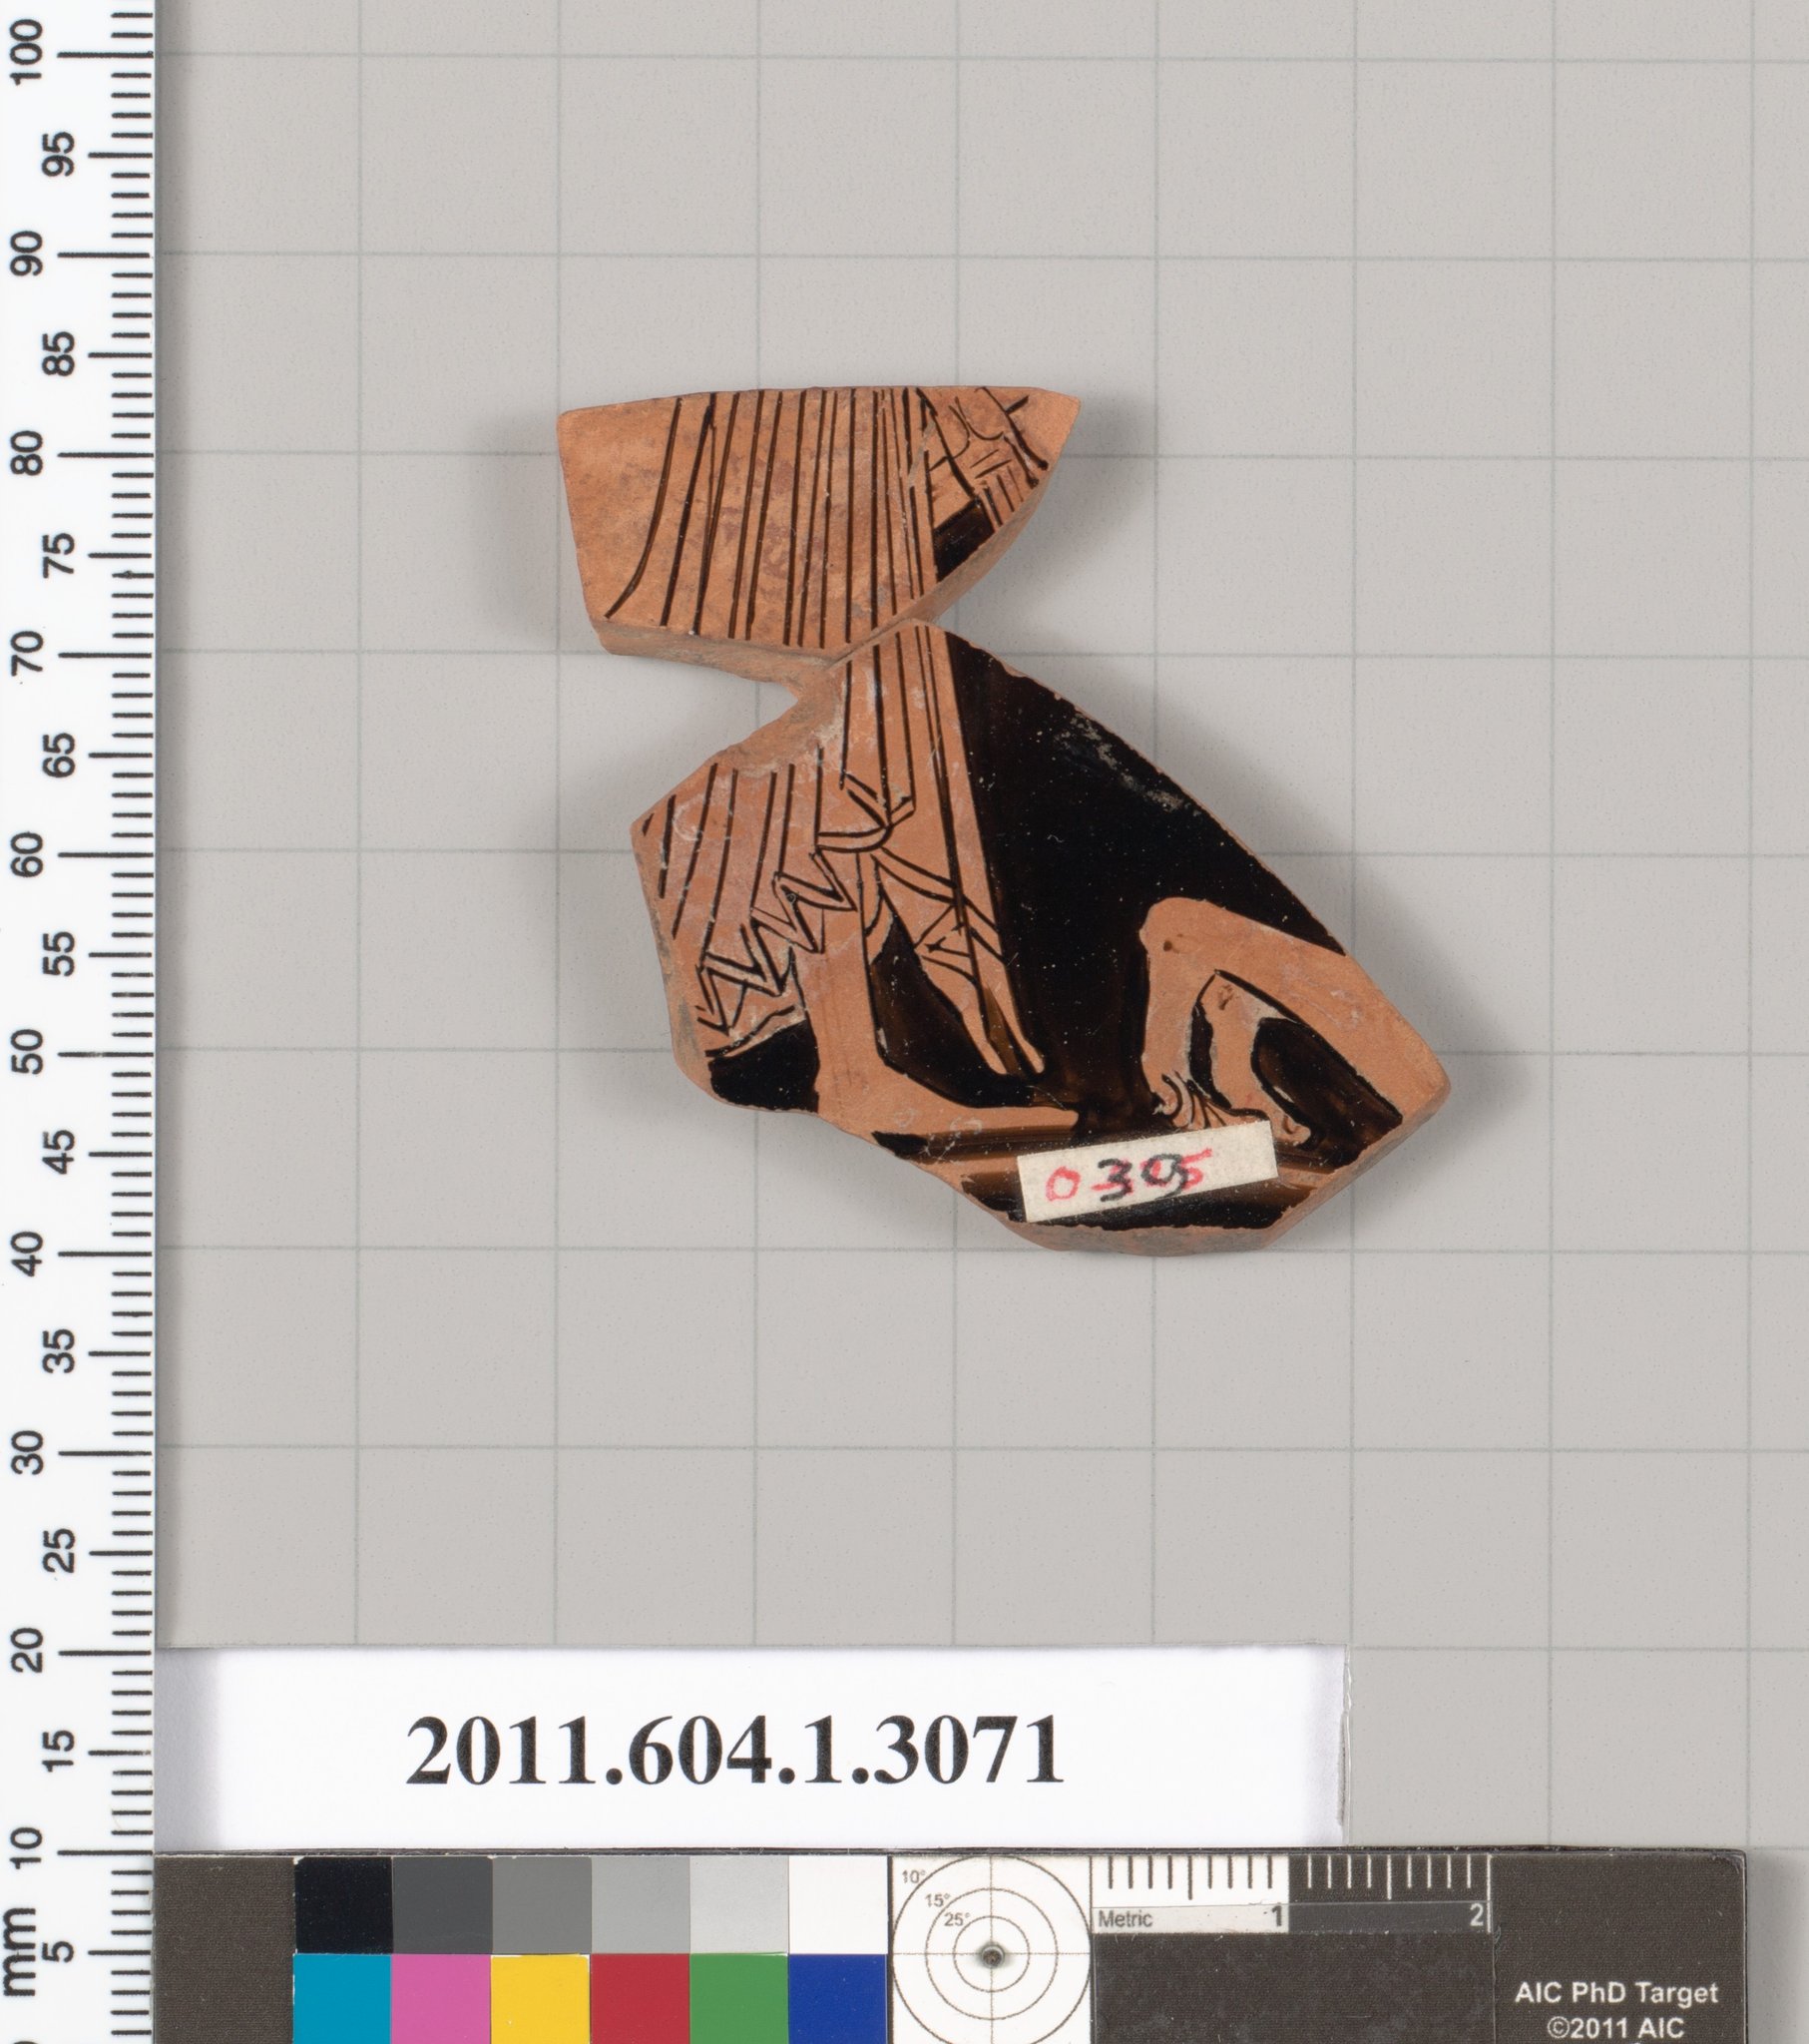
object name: kylix fragment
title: Terracotta fragment of a kylix (drinking cup)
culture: greek, attic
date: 500-480 BCE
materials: terracotta